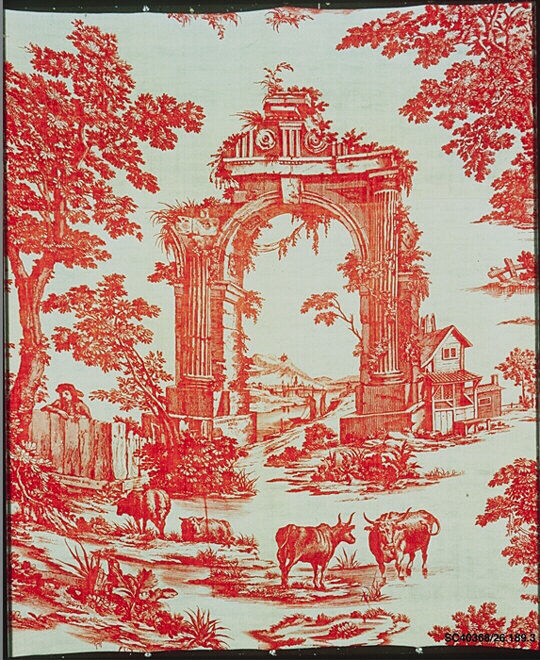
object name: furnishing textile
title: Pictorial print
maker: henry roberts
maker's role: engraver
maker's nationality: british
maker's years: 1710-1790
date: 1765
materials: cotton, linen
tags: gates,houses,bulls,trees